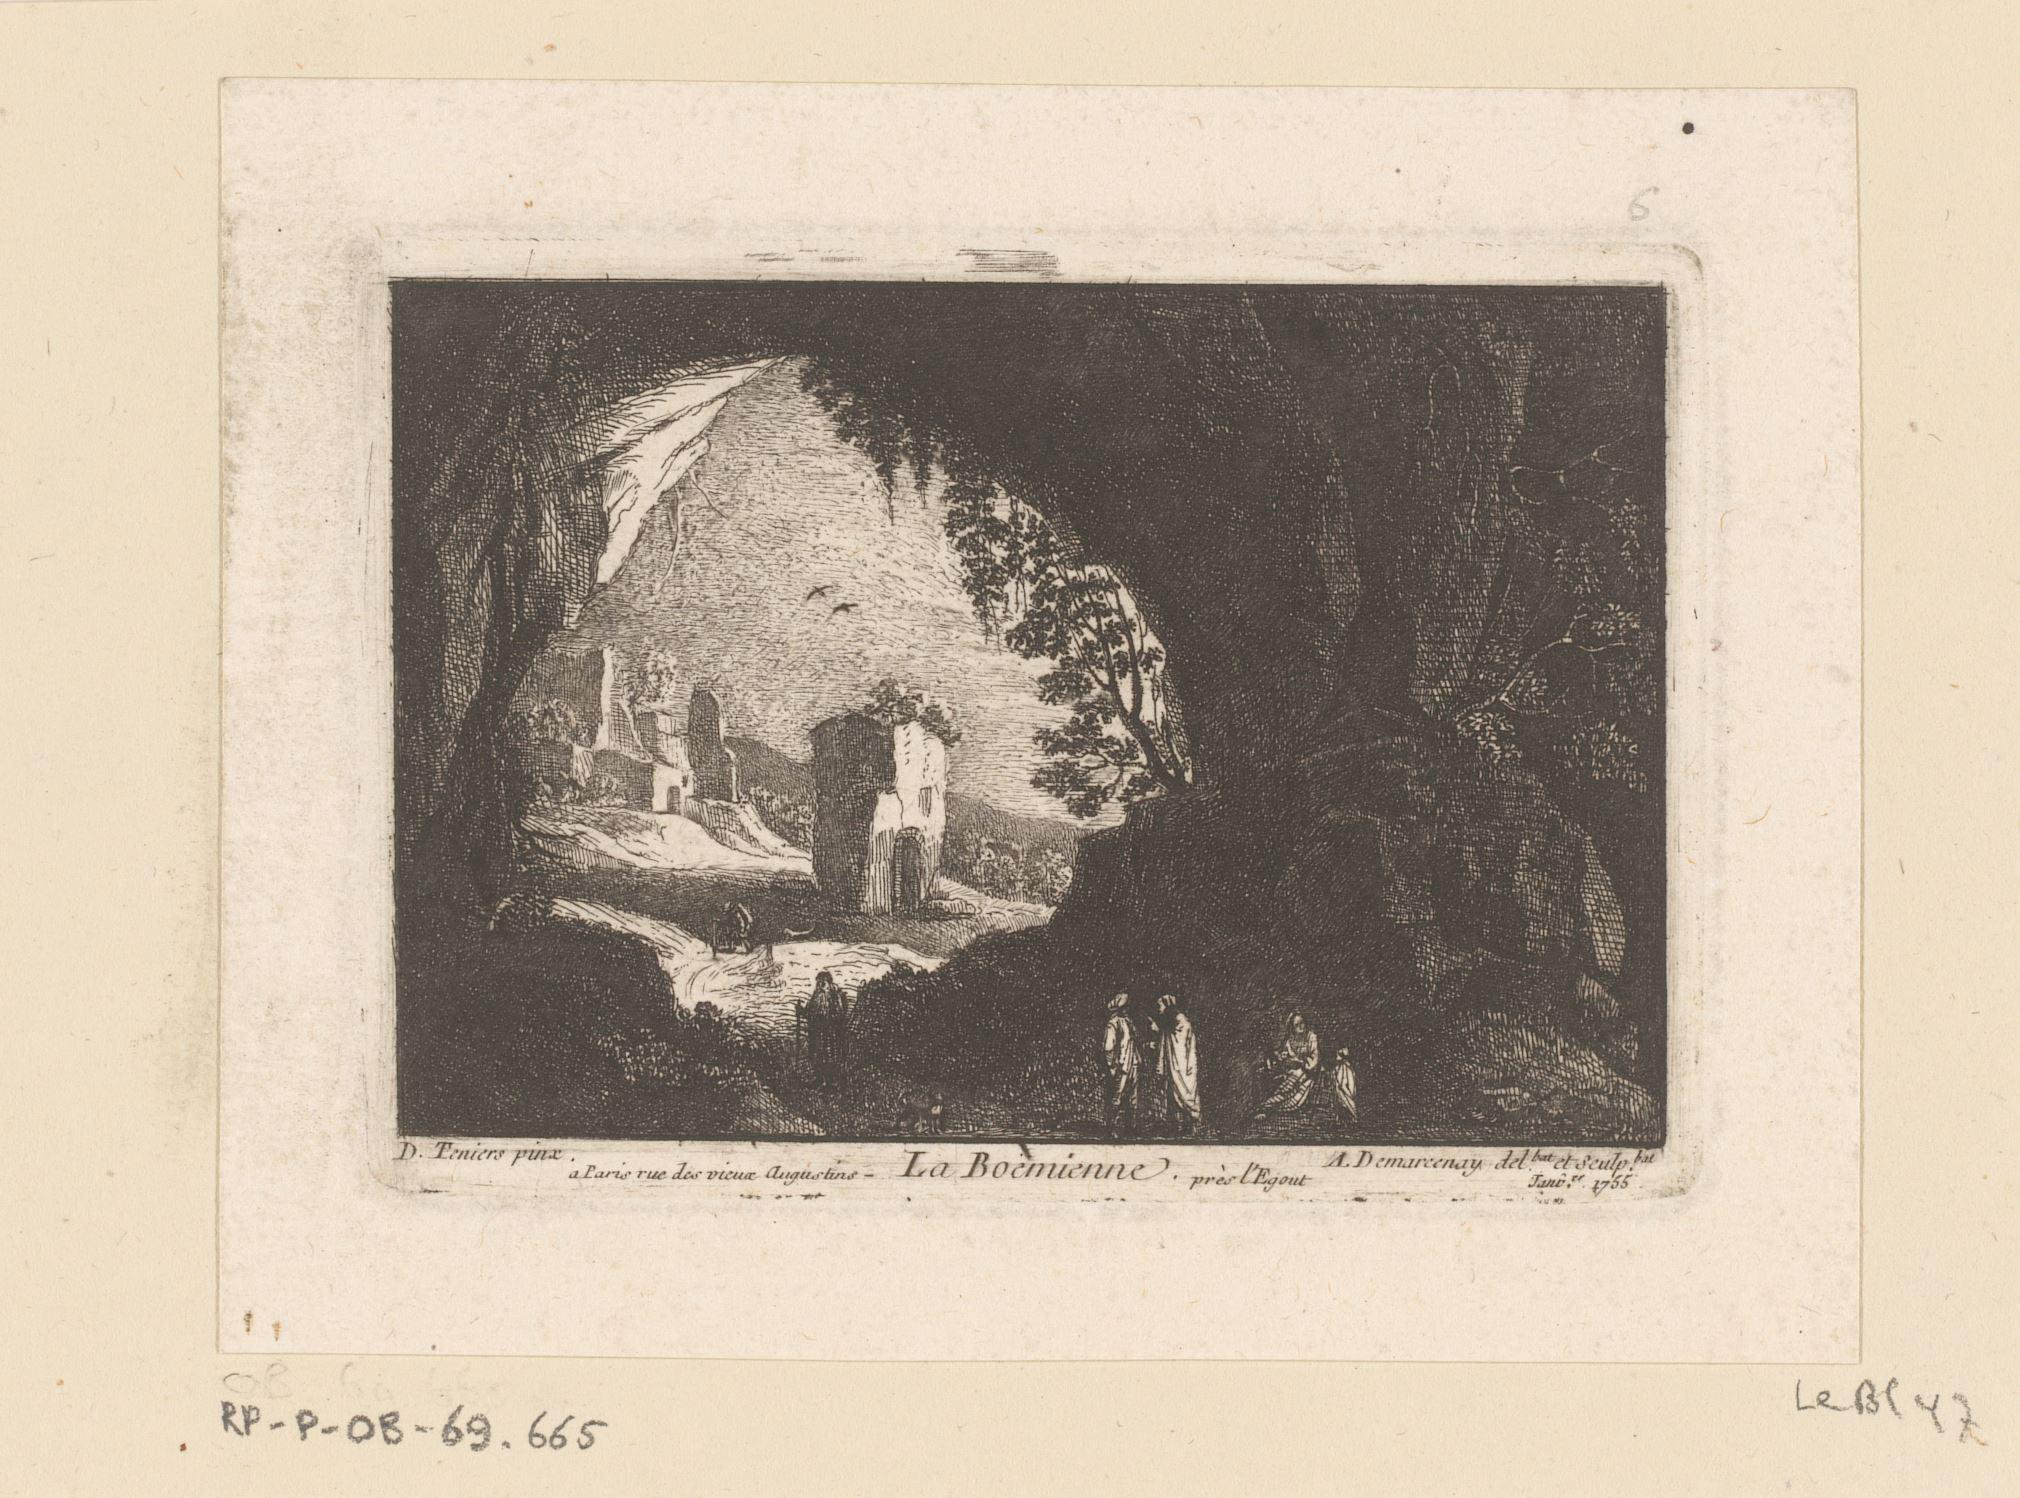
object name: print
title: La Bohemienne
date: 1701-1755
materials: paper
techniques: etching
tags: cave, grotto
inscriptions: collector's mark: Lugt 2228